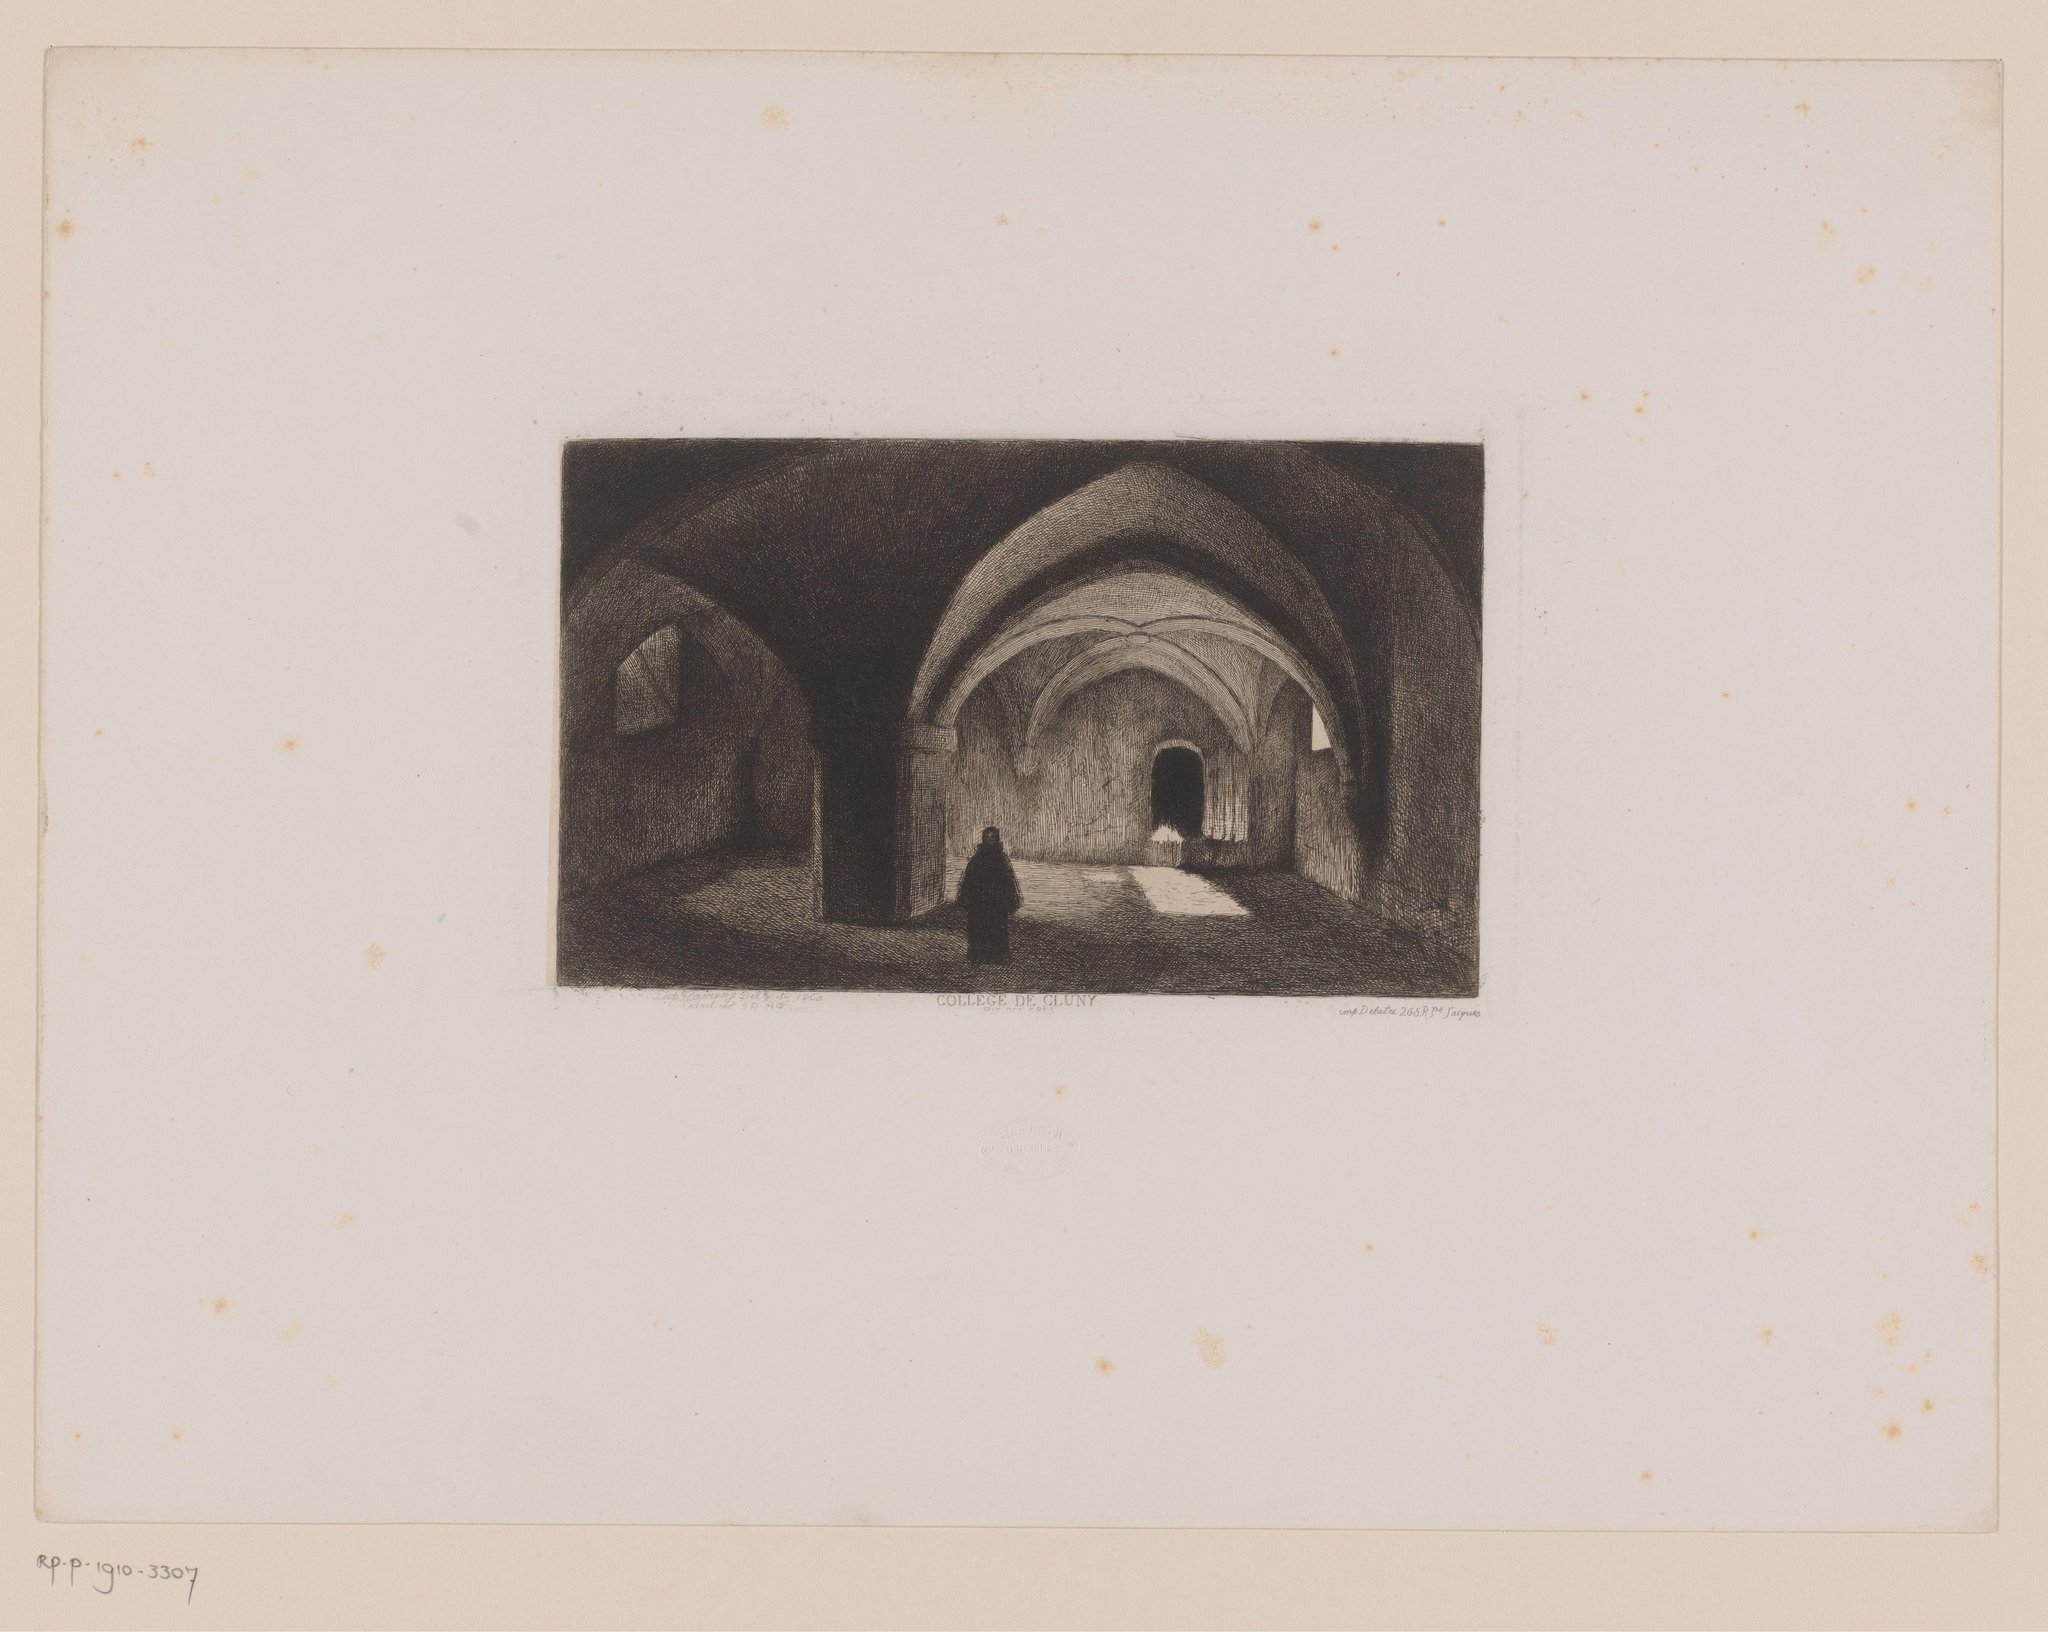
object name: print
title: Monnik in een duistere ruimte met gewelfd plafond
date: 1860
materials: paper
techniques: etching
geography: paris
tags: monk(s), friar(s), basement, cellar, paris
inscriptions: workshop stamp: ‘A. Cadart editeur 3 rue St. Fiacre Paris’, collector's mark: Lugt 2228